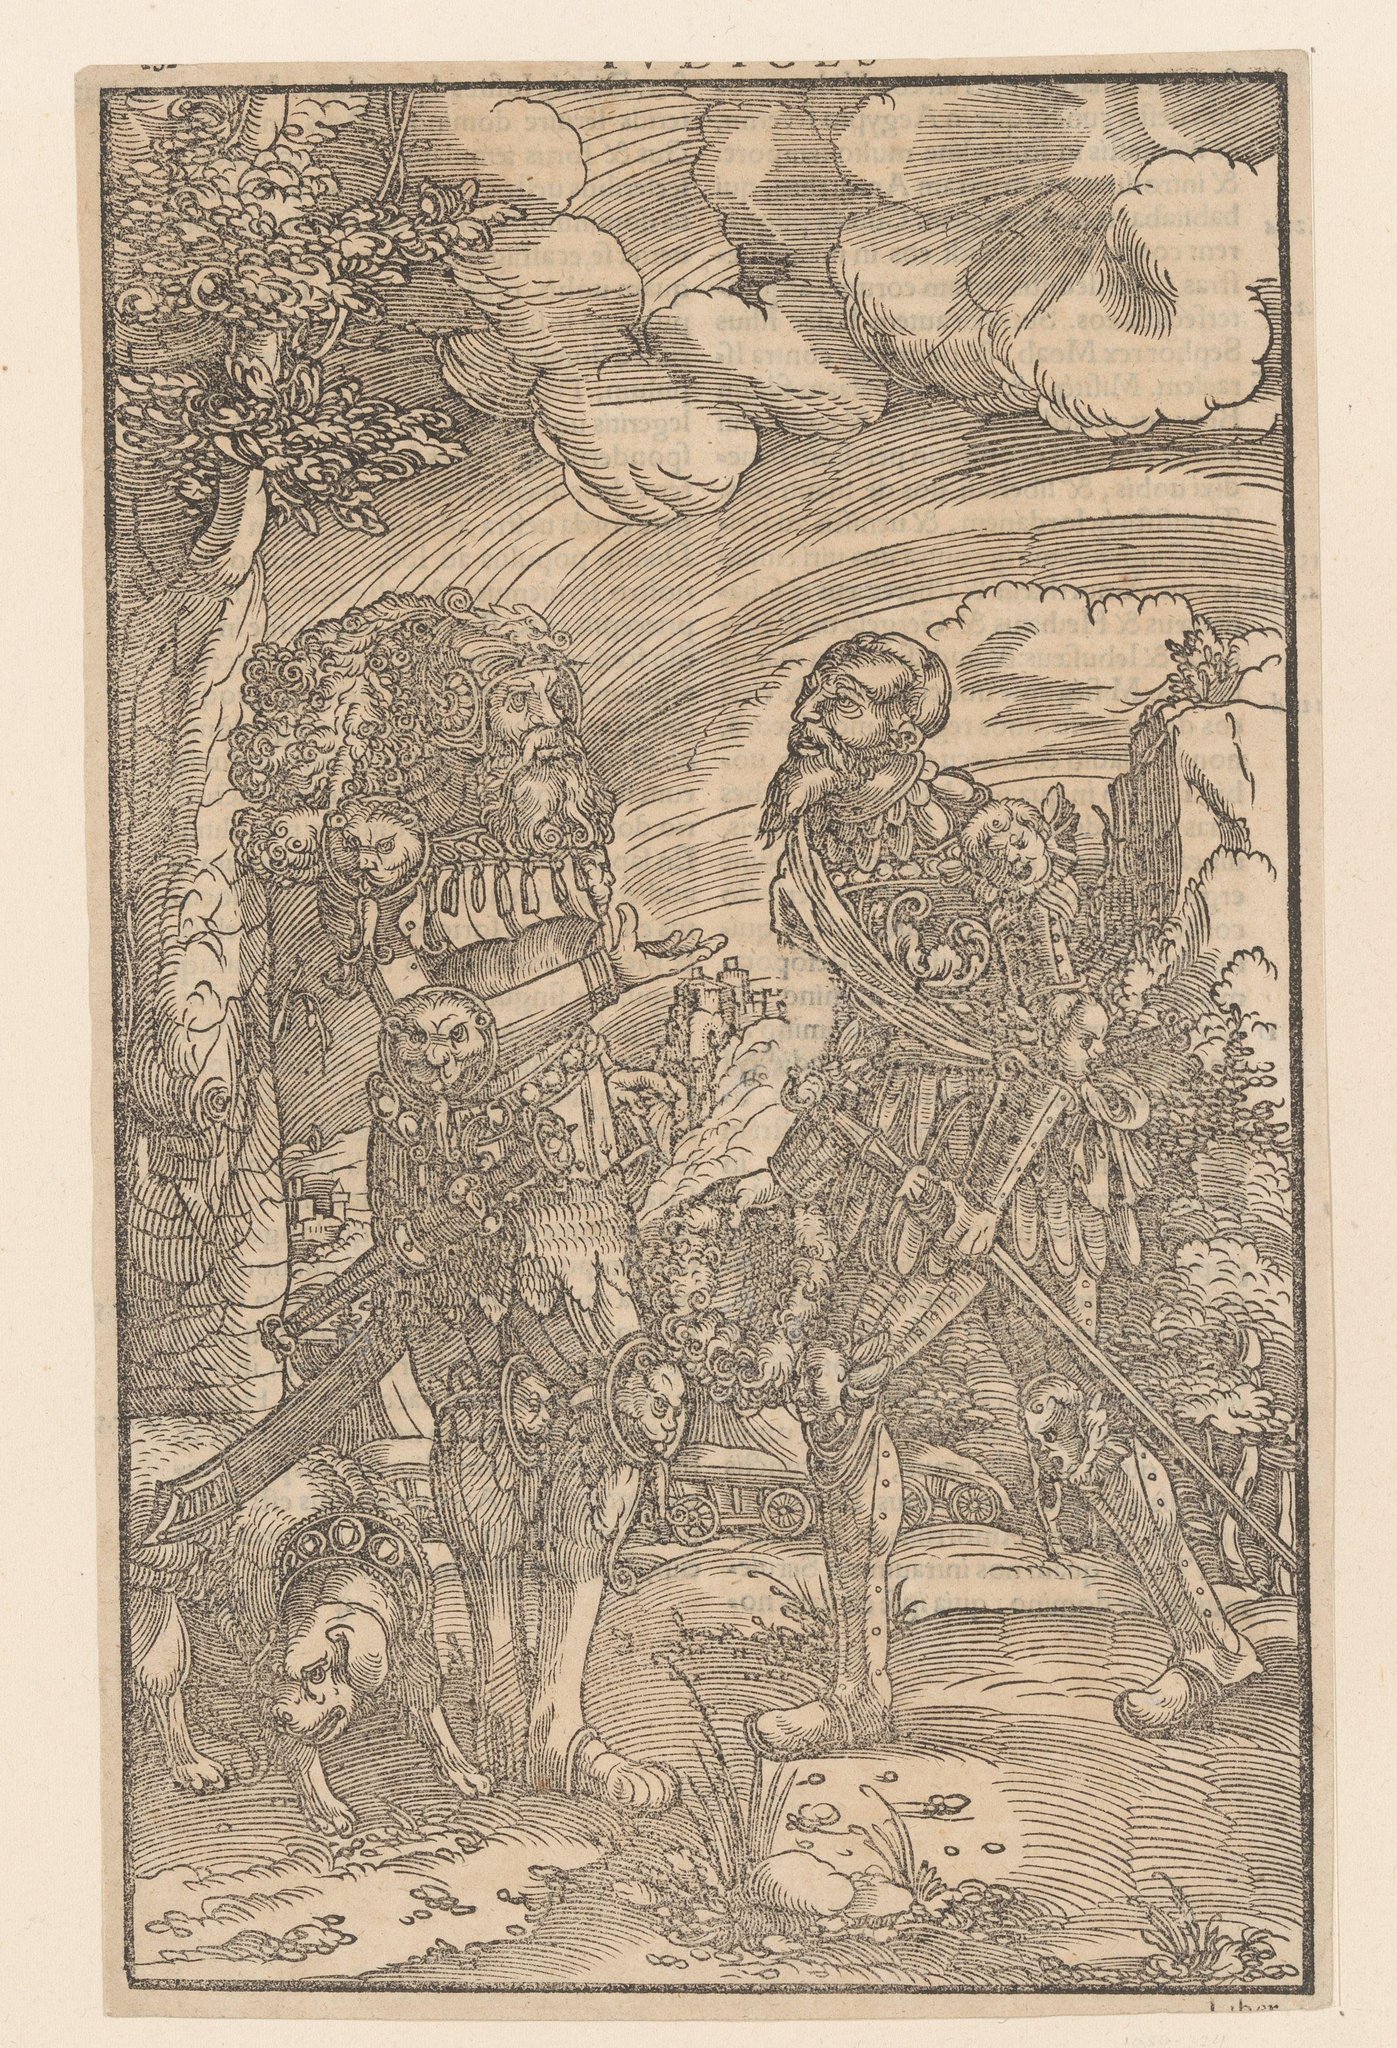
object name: book illustration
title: Twee rechters van Israël in harnas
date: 1541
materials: paper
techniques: woodcut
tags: the time of the judges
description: Prent afkomstig uit: Luther, Martin. Die Propheten alle deudsch (...). Leipzig: Nicolaus Wolrab, 1541.